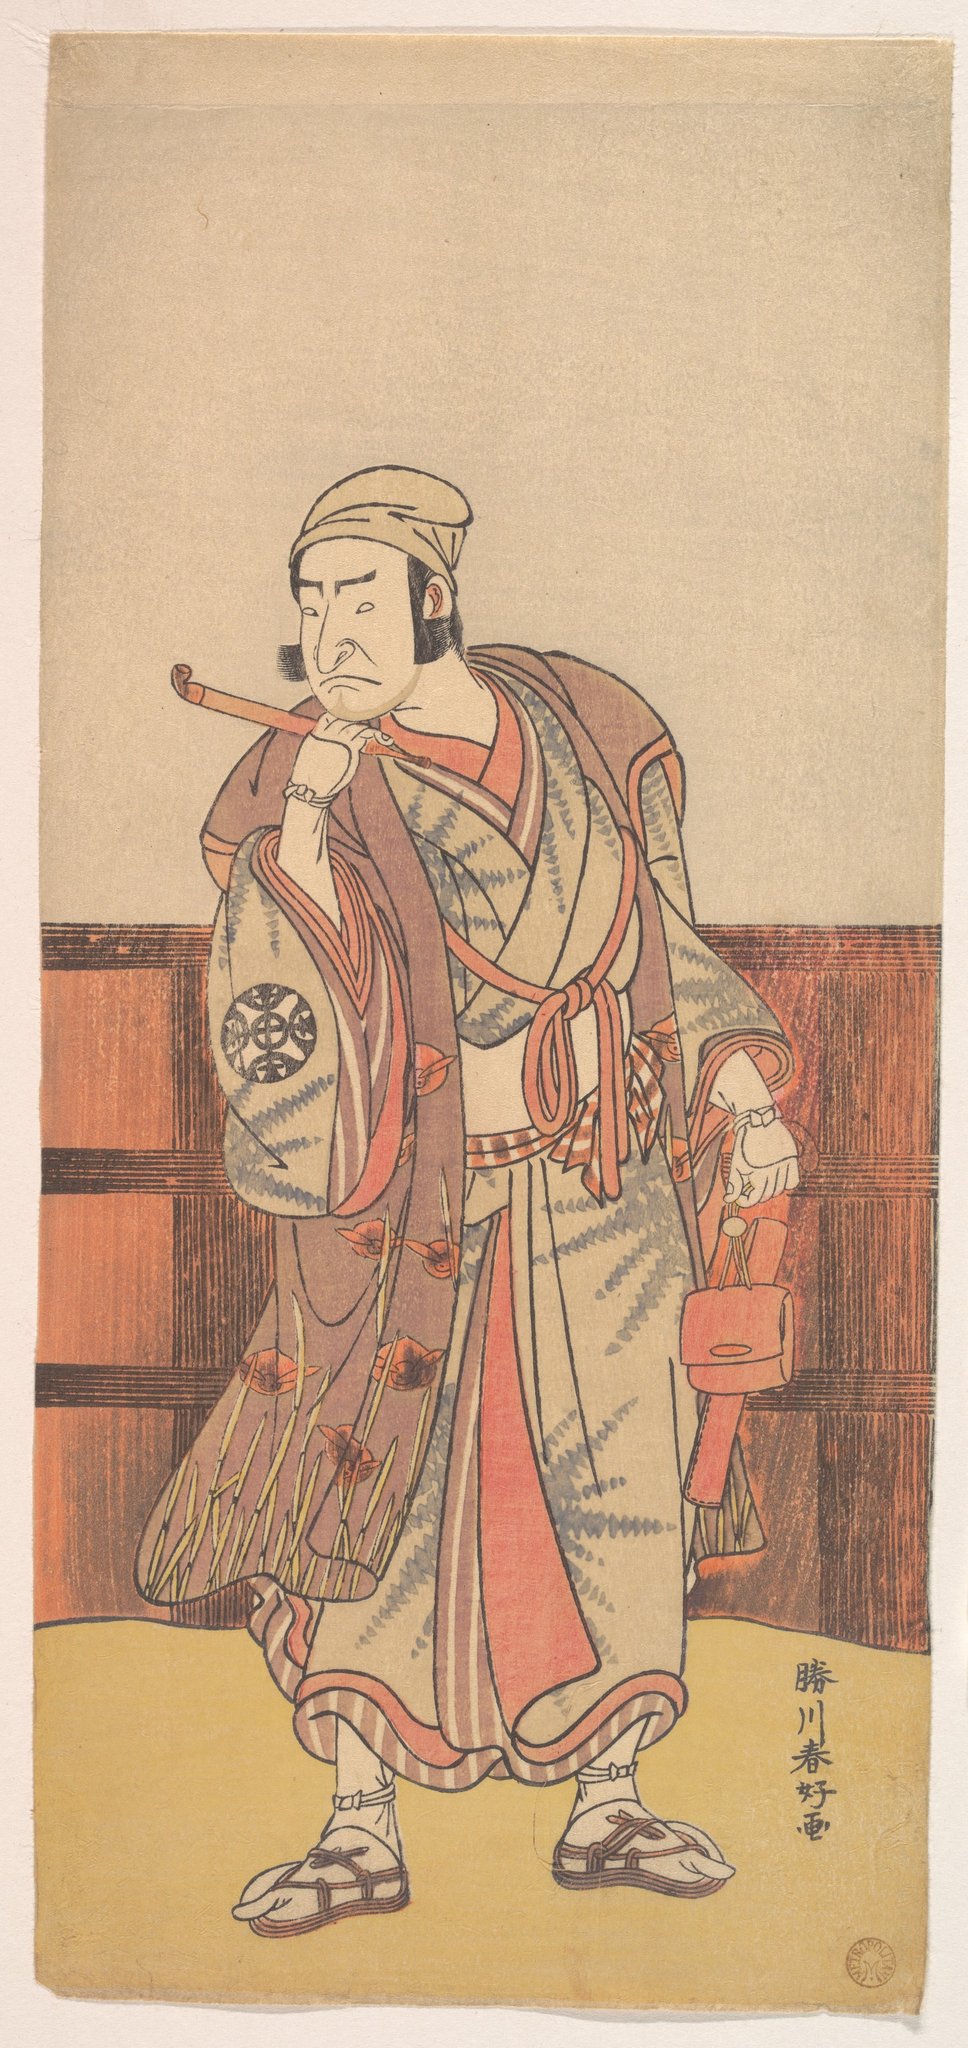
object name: print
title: Kabuki Actor Nakamura Nakazō I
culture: japanese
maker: katsukawa shunkō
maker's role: artist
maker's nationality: japanese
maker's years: 1743-1812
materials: ink, paper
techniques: nishiki e, woodblock print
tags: men,actors